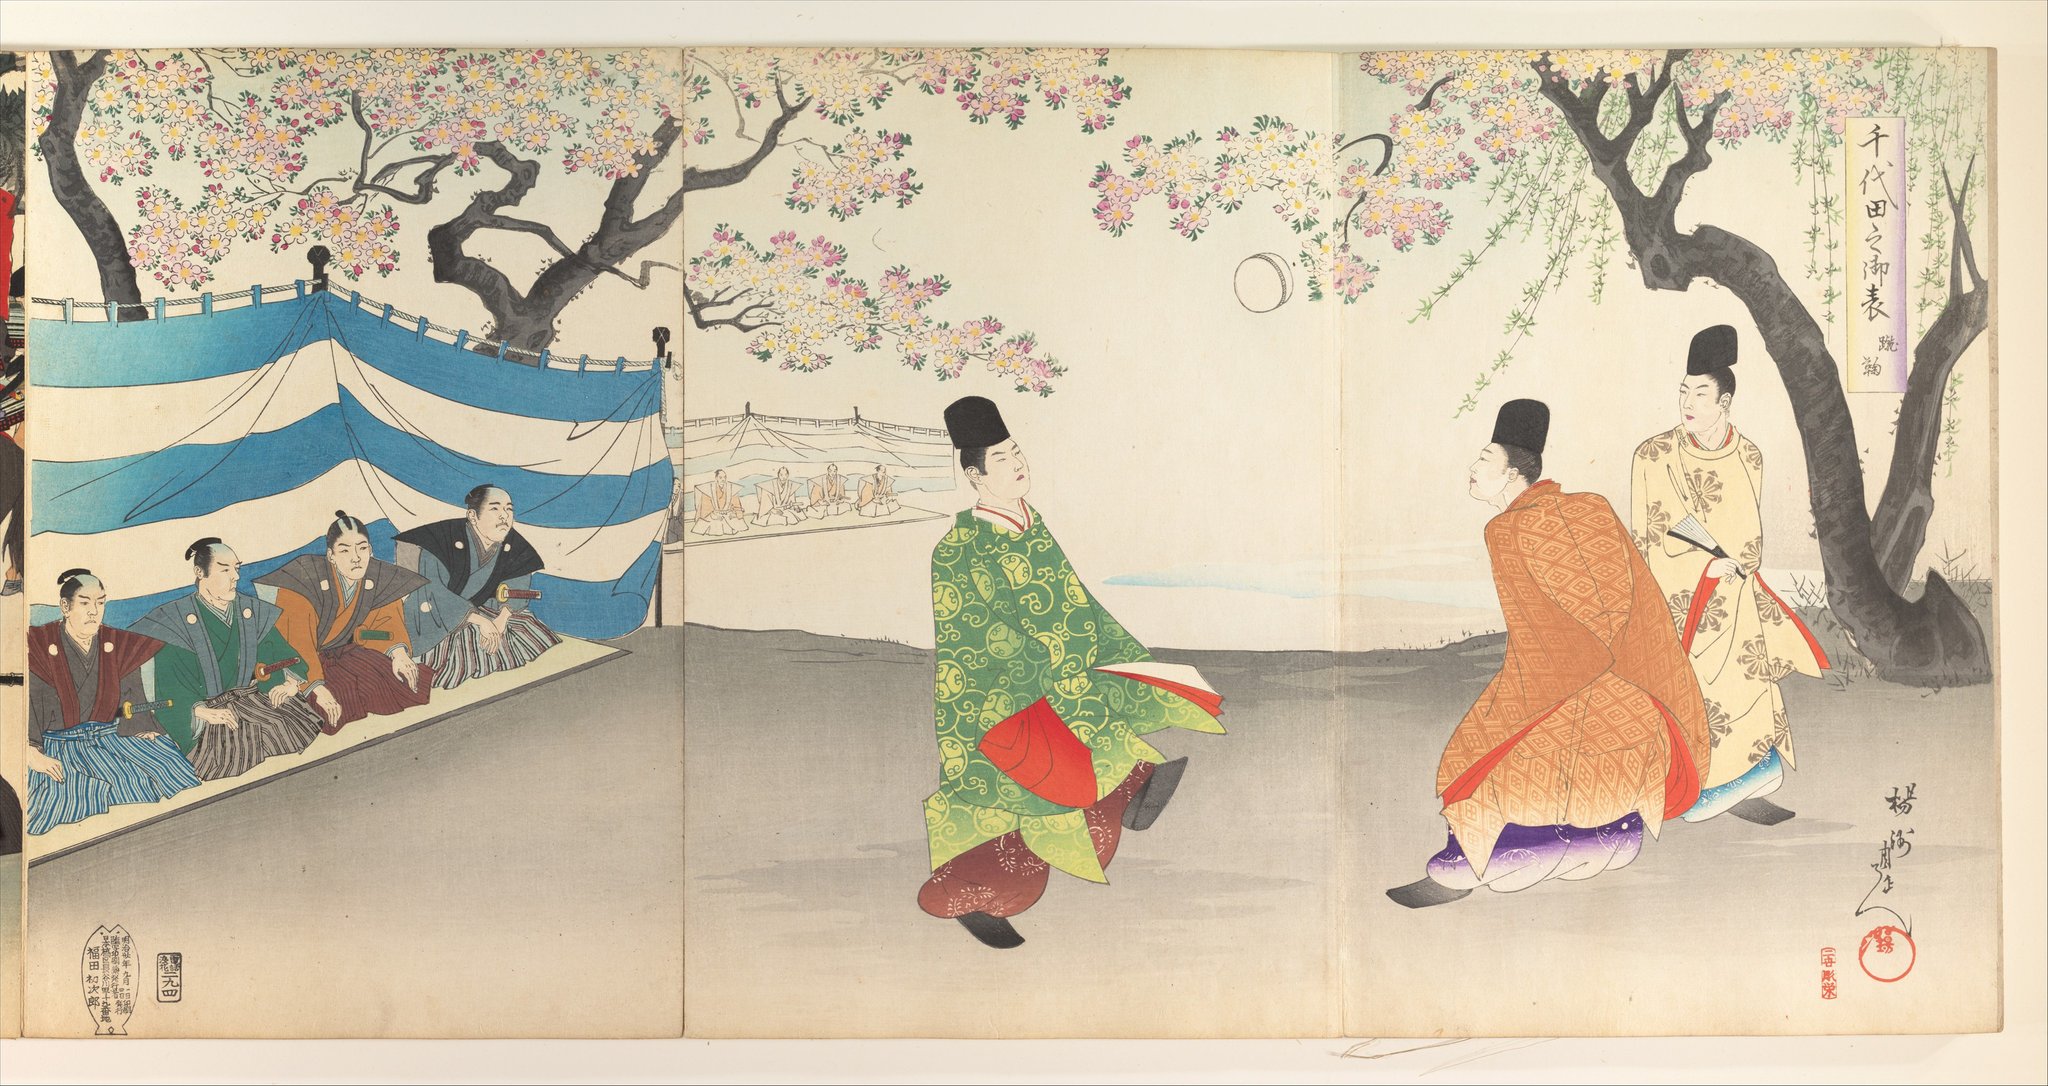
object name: print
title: Chiyoda Castle (Album of Men)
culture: japanese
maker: yōshū (hashimoto) chikanobu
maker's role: artist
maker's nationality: japanese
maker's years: 1838-1912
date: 1897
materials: ink, paper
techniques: woodblock print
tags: men,trees